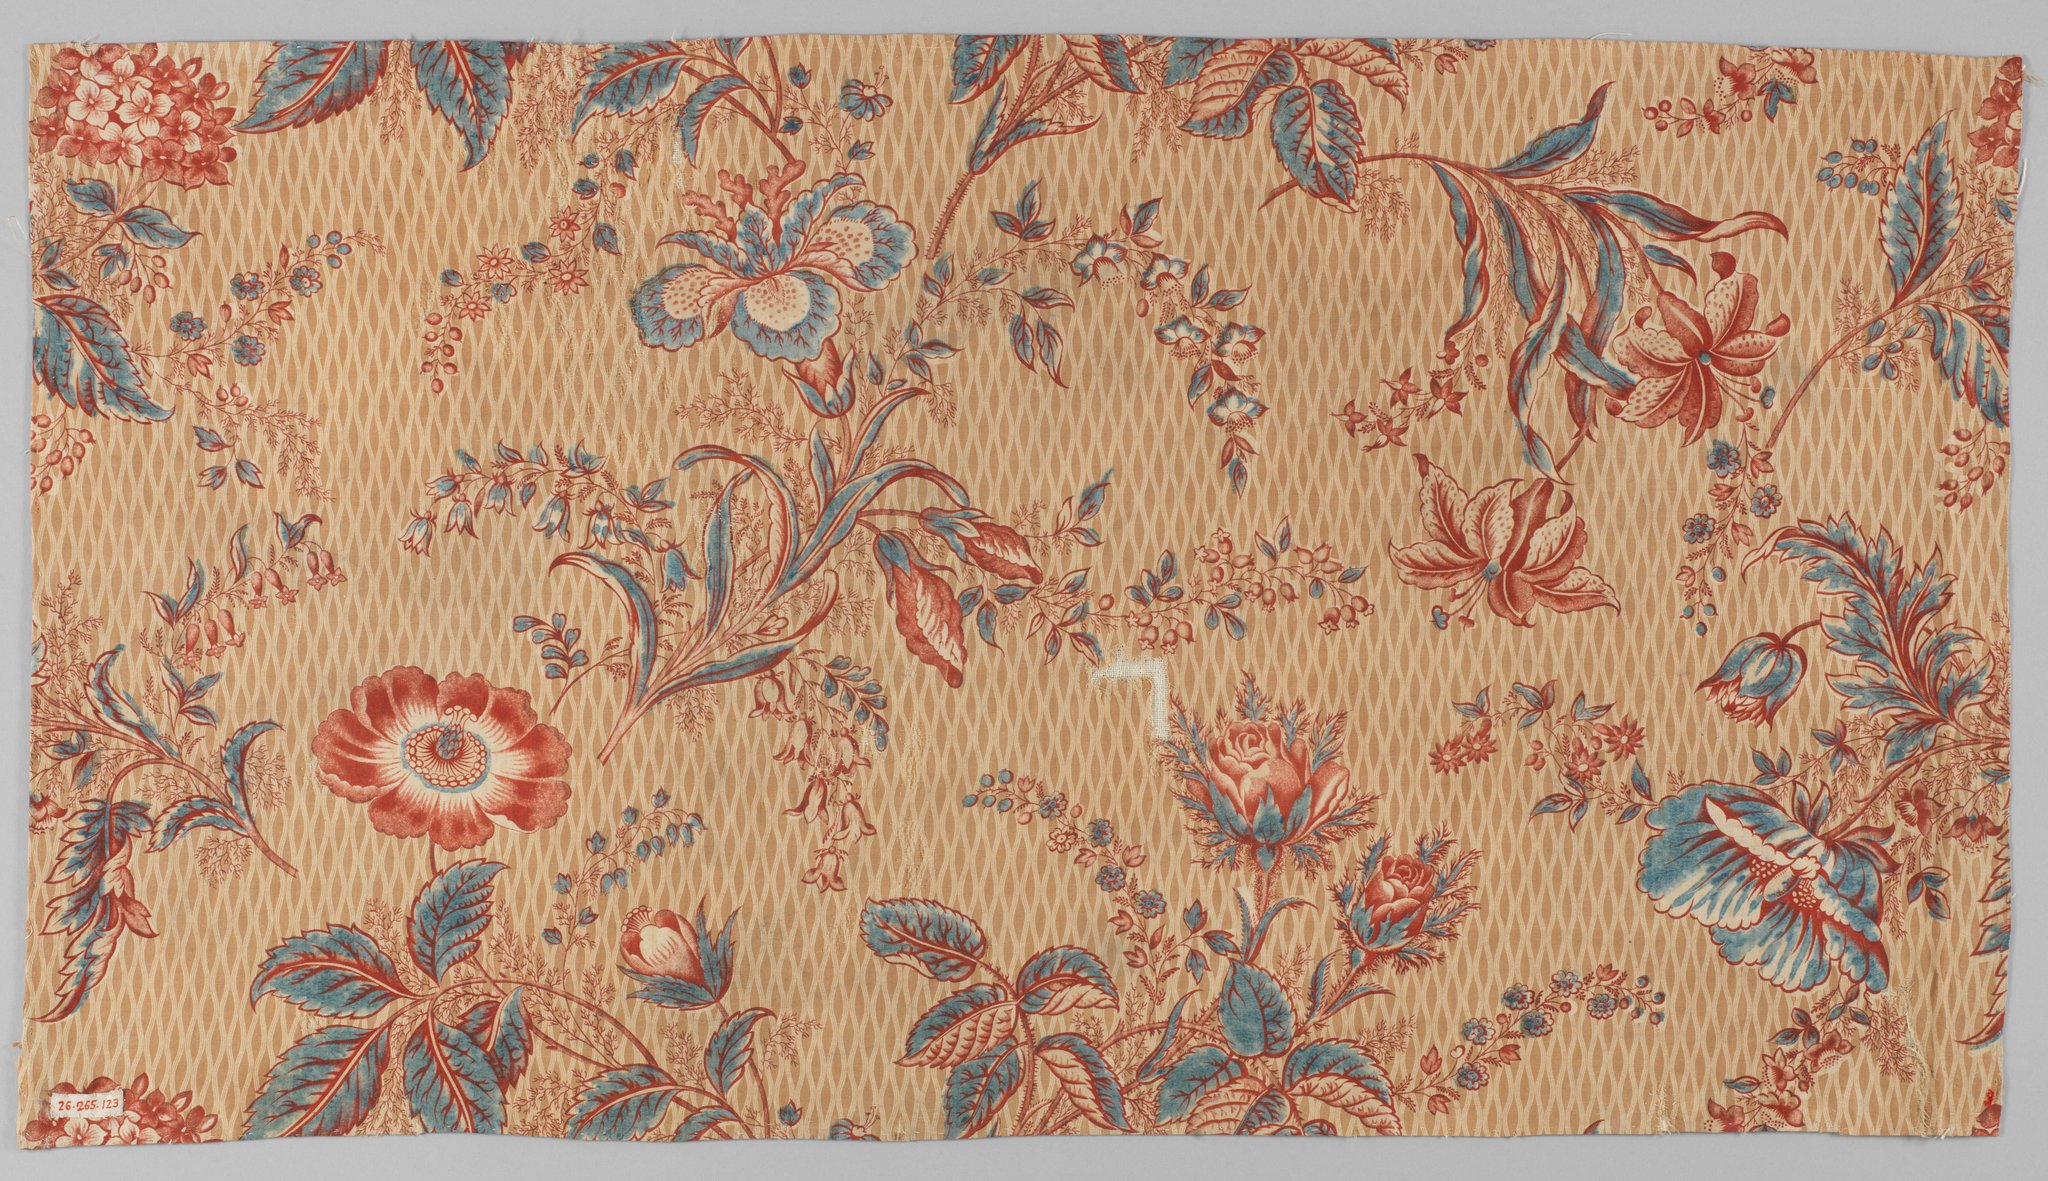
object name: piece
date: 1830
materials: cotton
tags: flowers